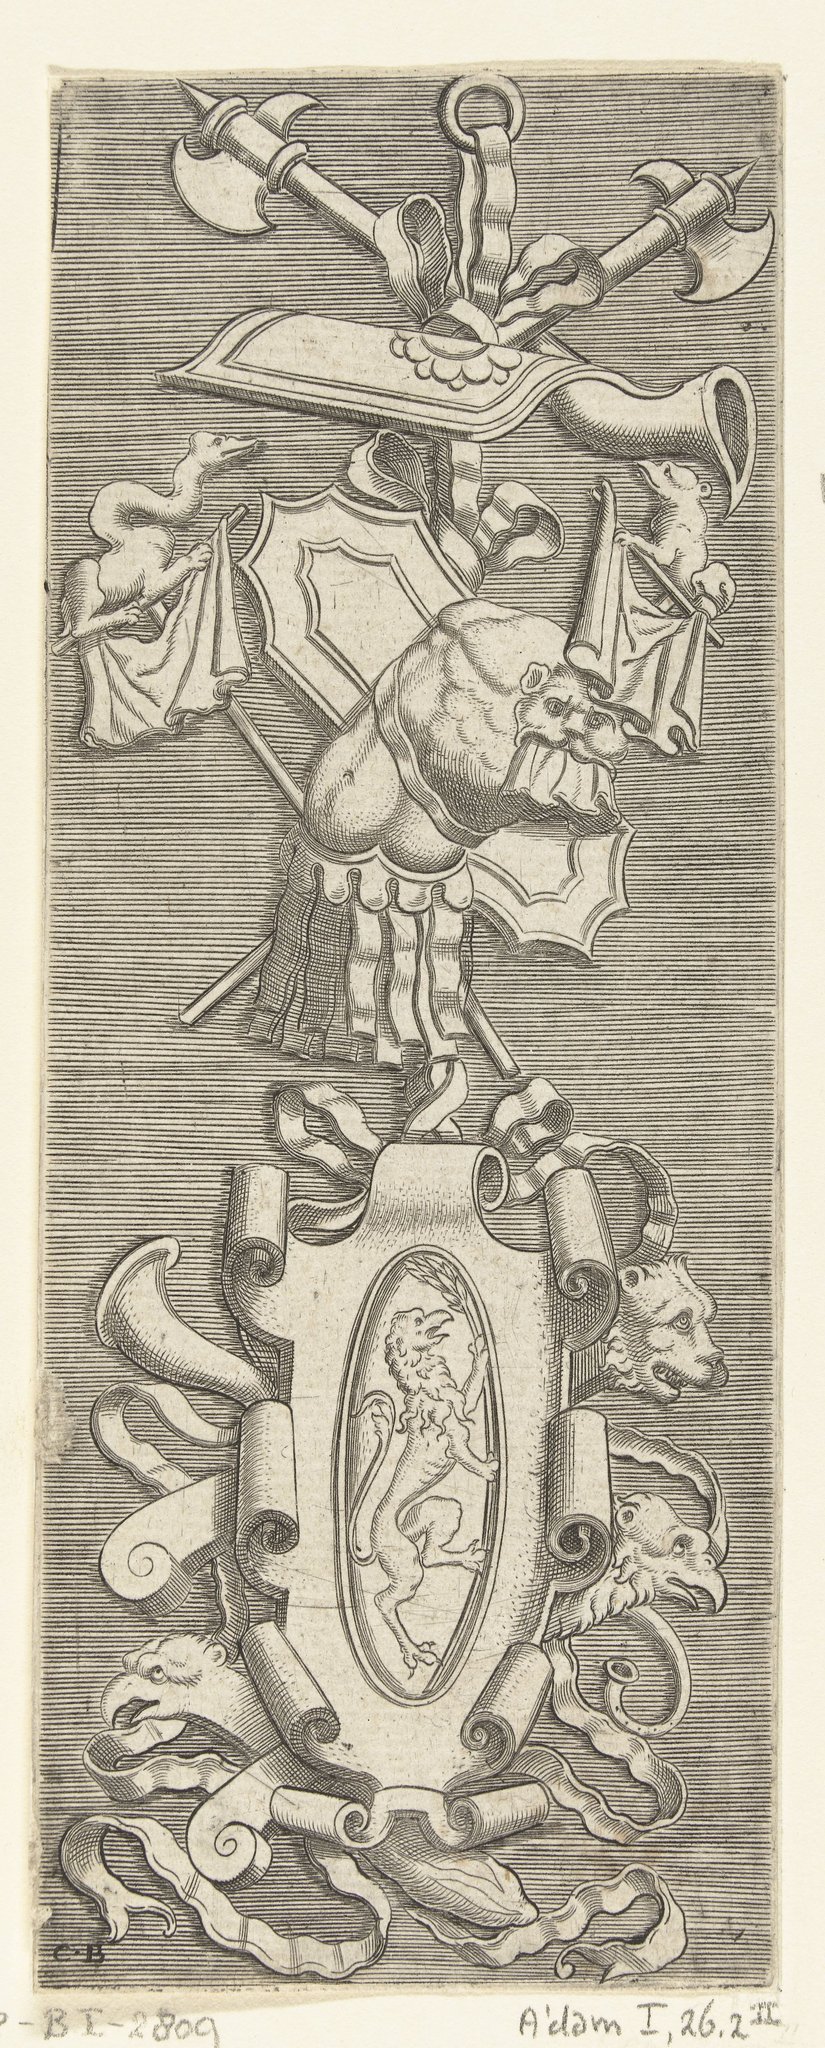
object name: print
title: Vlakdecoraties met wapentrofeeën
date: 1516-1565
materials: paper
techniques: engraving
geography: netherlands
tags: trophy, i.e.: decorative arrangement of symbolic or typical objects ~ ornament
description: Onderaan hangt een schild met rolwerk rondom een leeuw. Daarboven hangt een wapenrusting. Hoort bij 5 bladen uit een serie van 7.